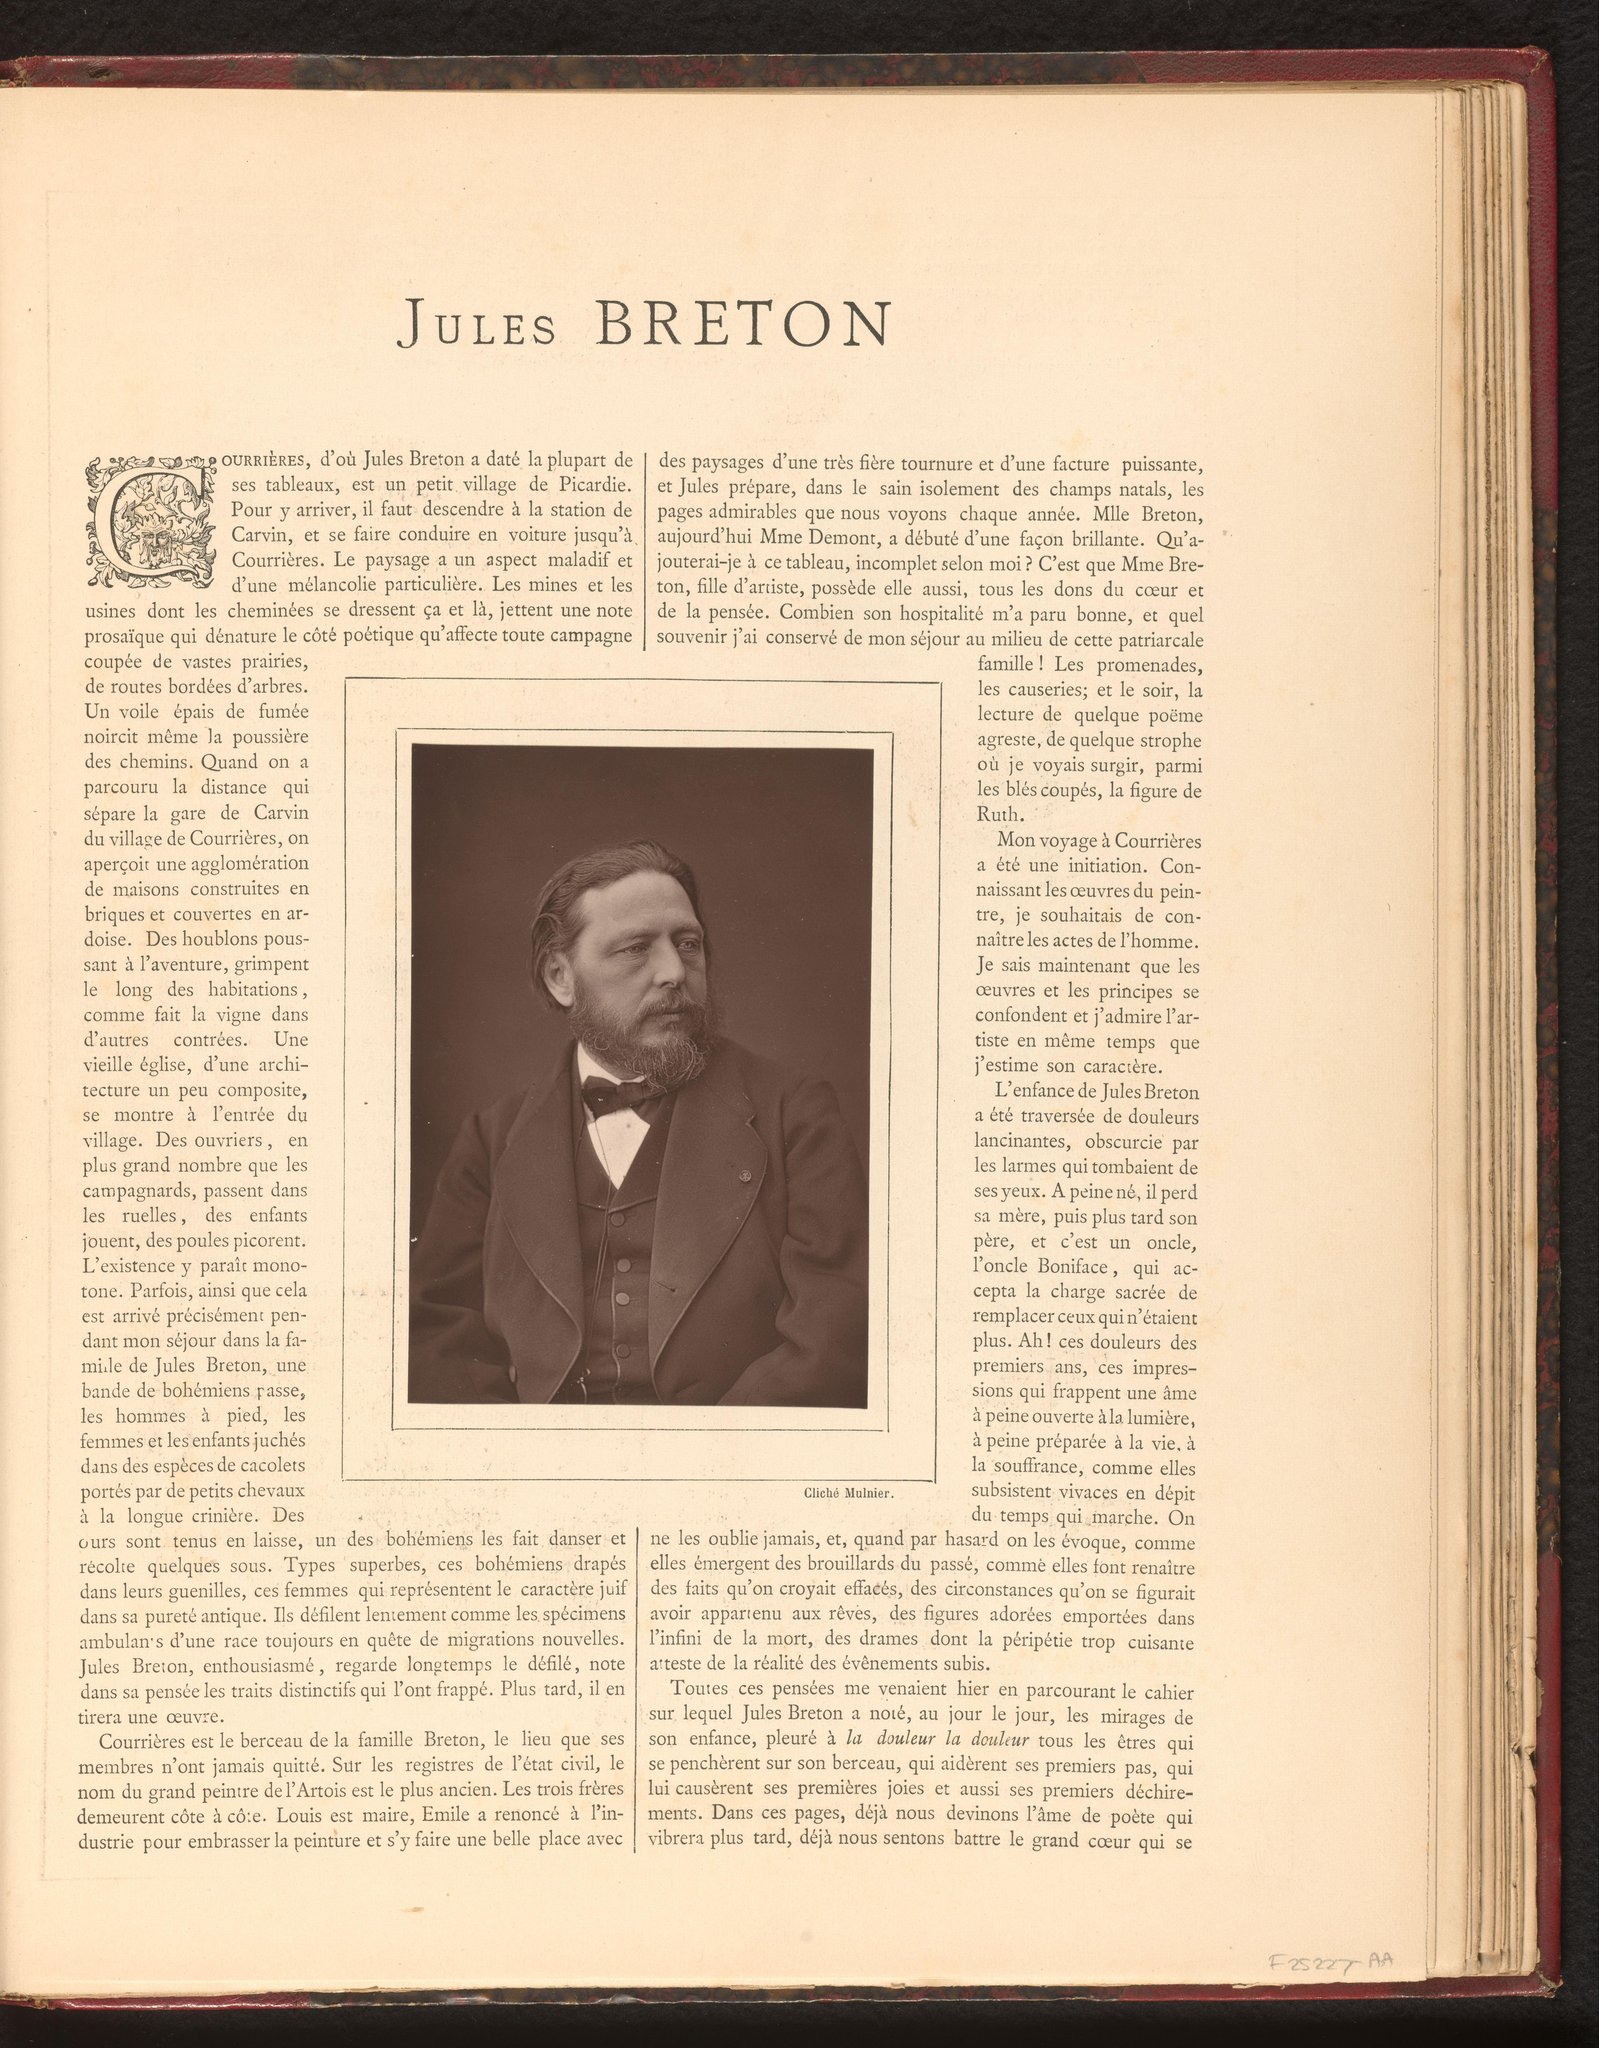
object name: page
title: Jules Breton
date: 1877-1882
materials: paper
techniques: woodburytype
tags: painter, jules breton, historical persons